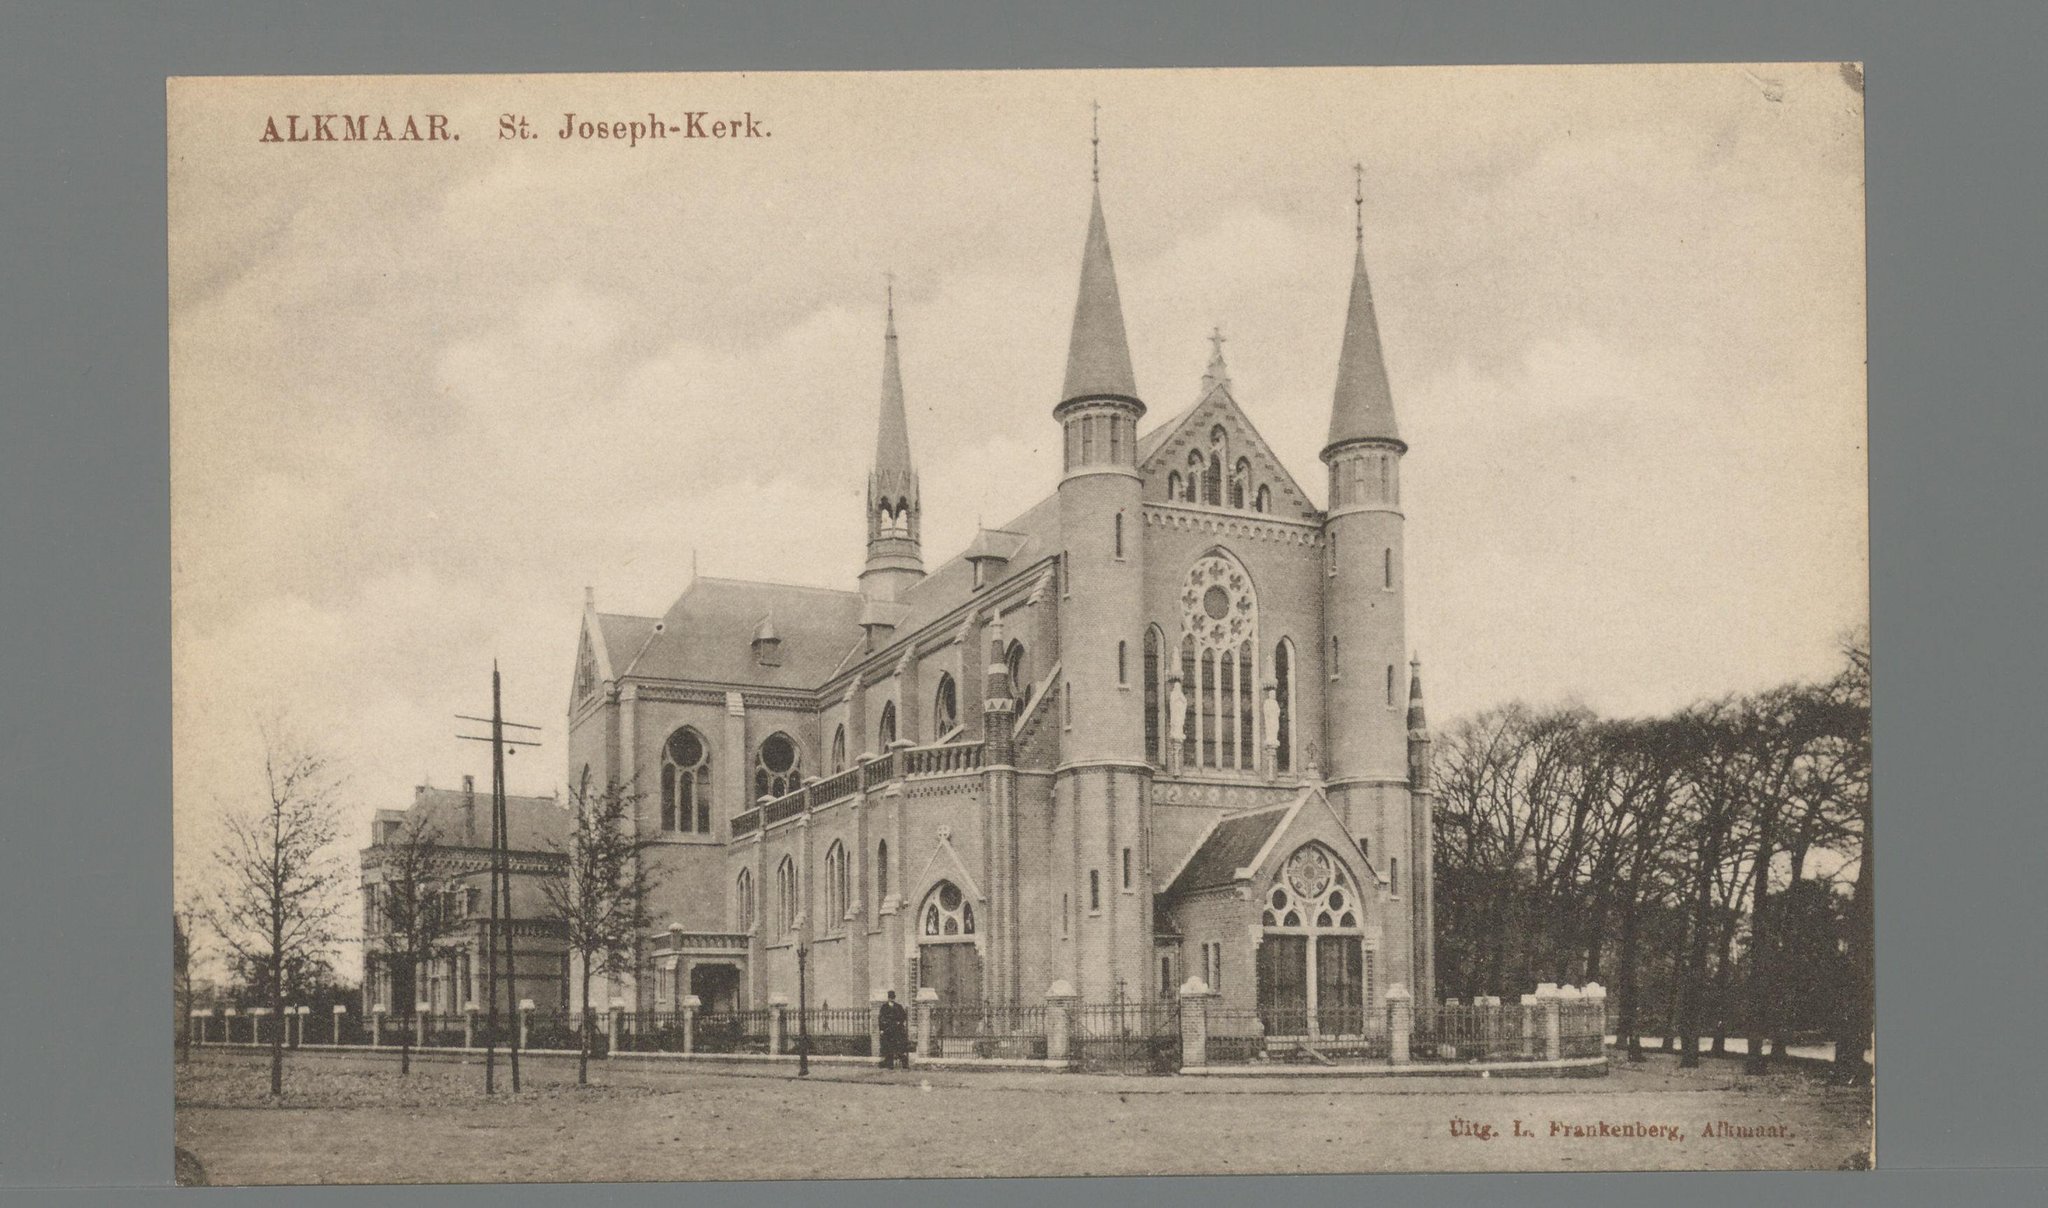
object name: ansichtkaart, prentbriefkaart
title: Alkmaar. St. Joseph-Kerk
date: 1905-1936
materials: cardboard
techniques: photograph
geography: alkmaar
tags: church (exterior)